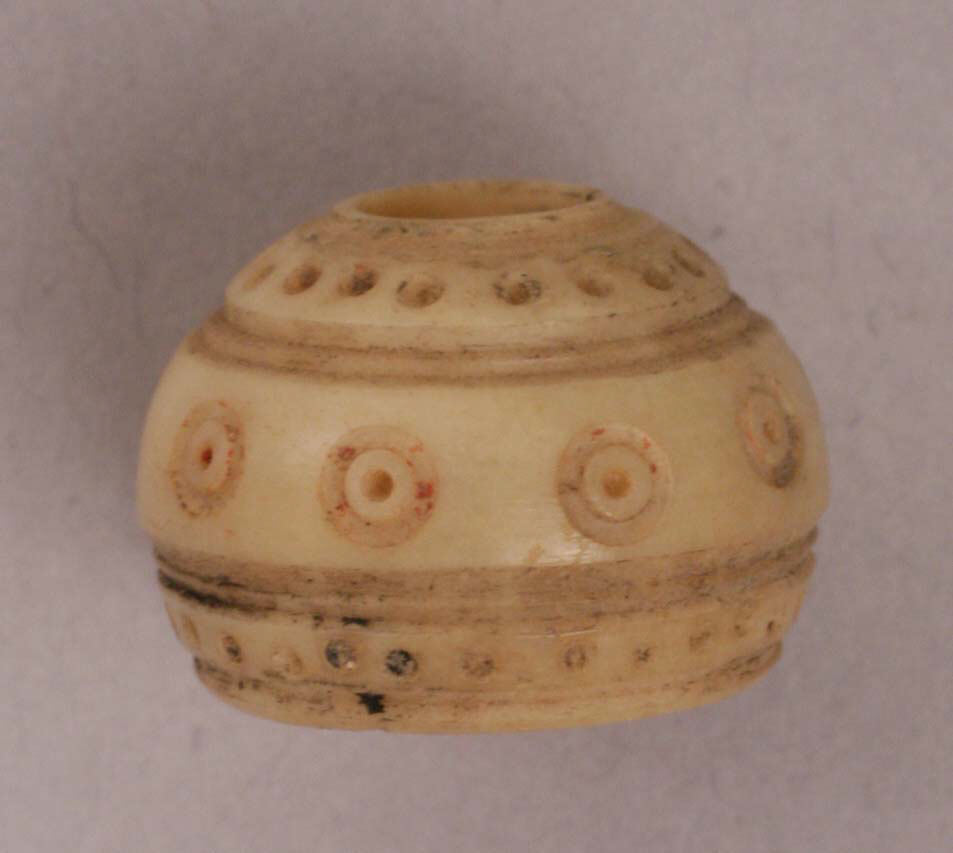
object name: button or bead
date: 801-1000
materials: bone, paint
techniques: incising, inlay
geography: iran